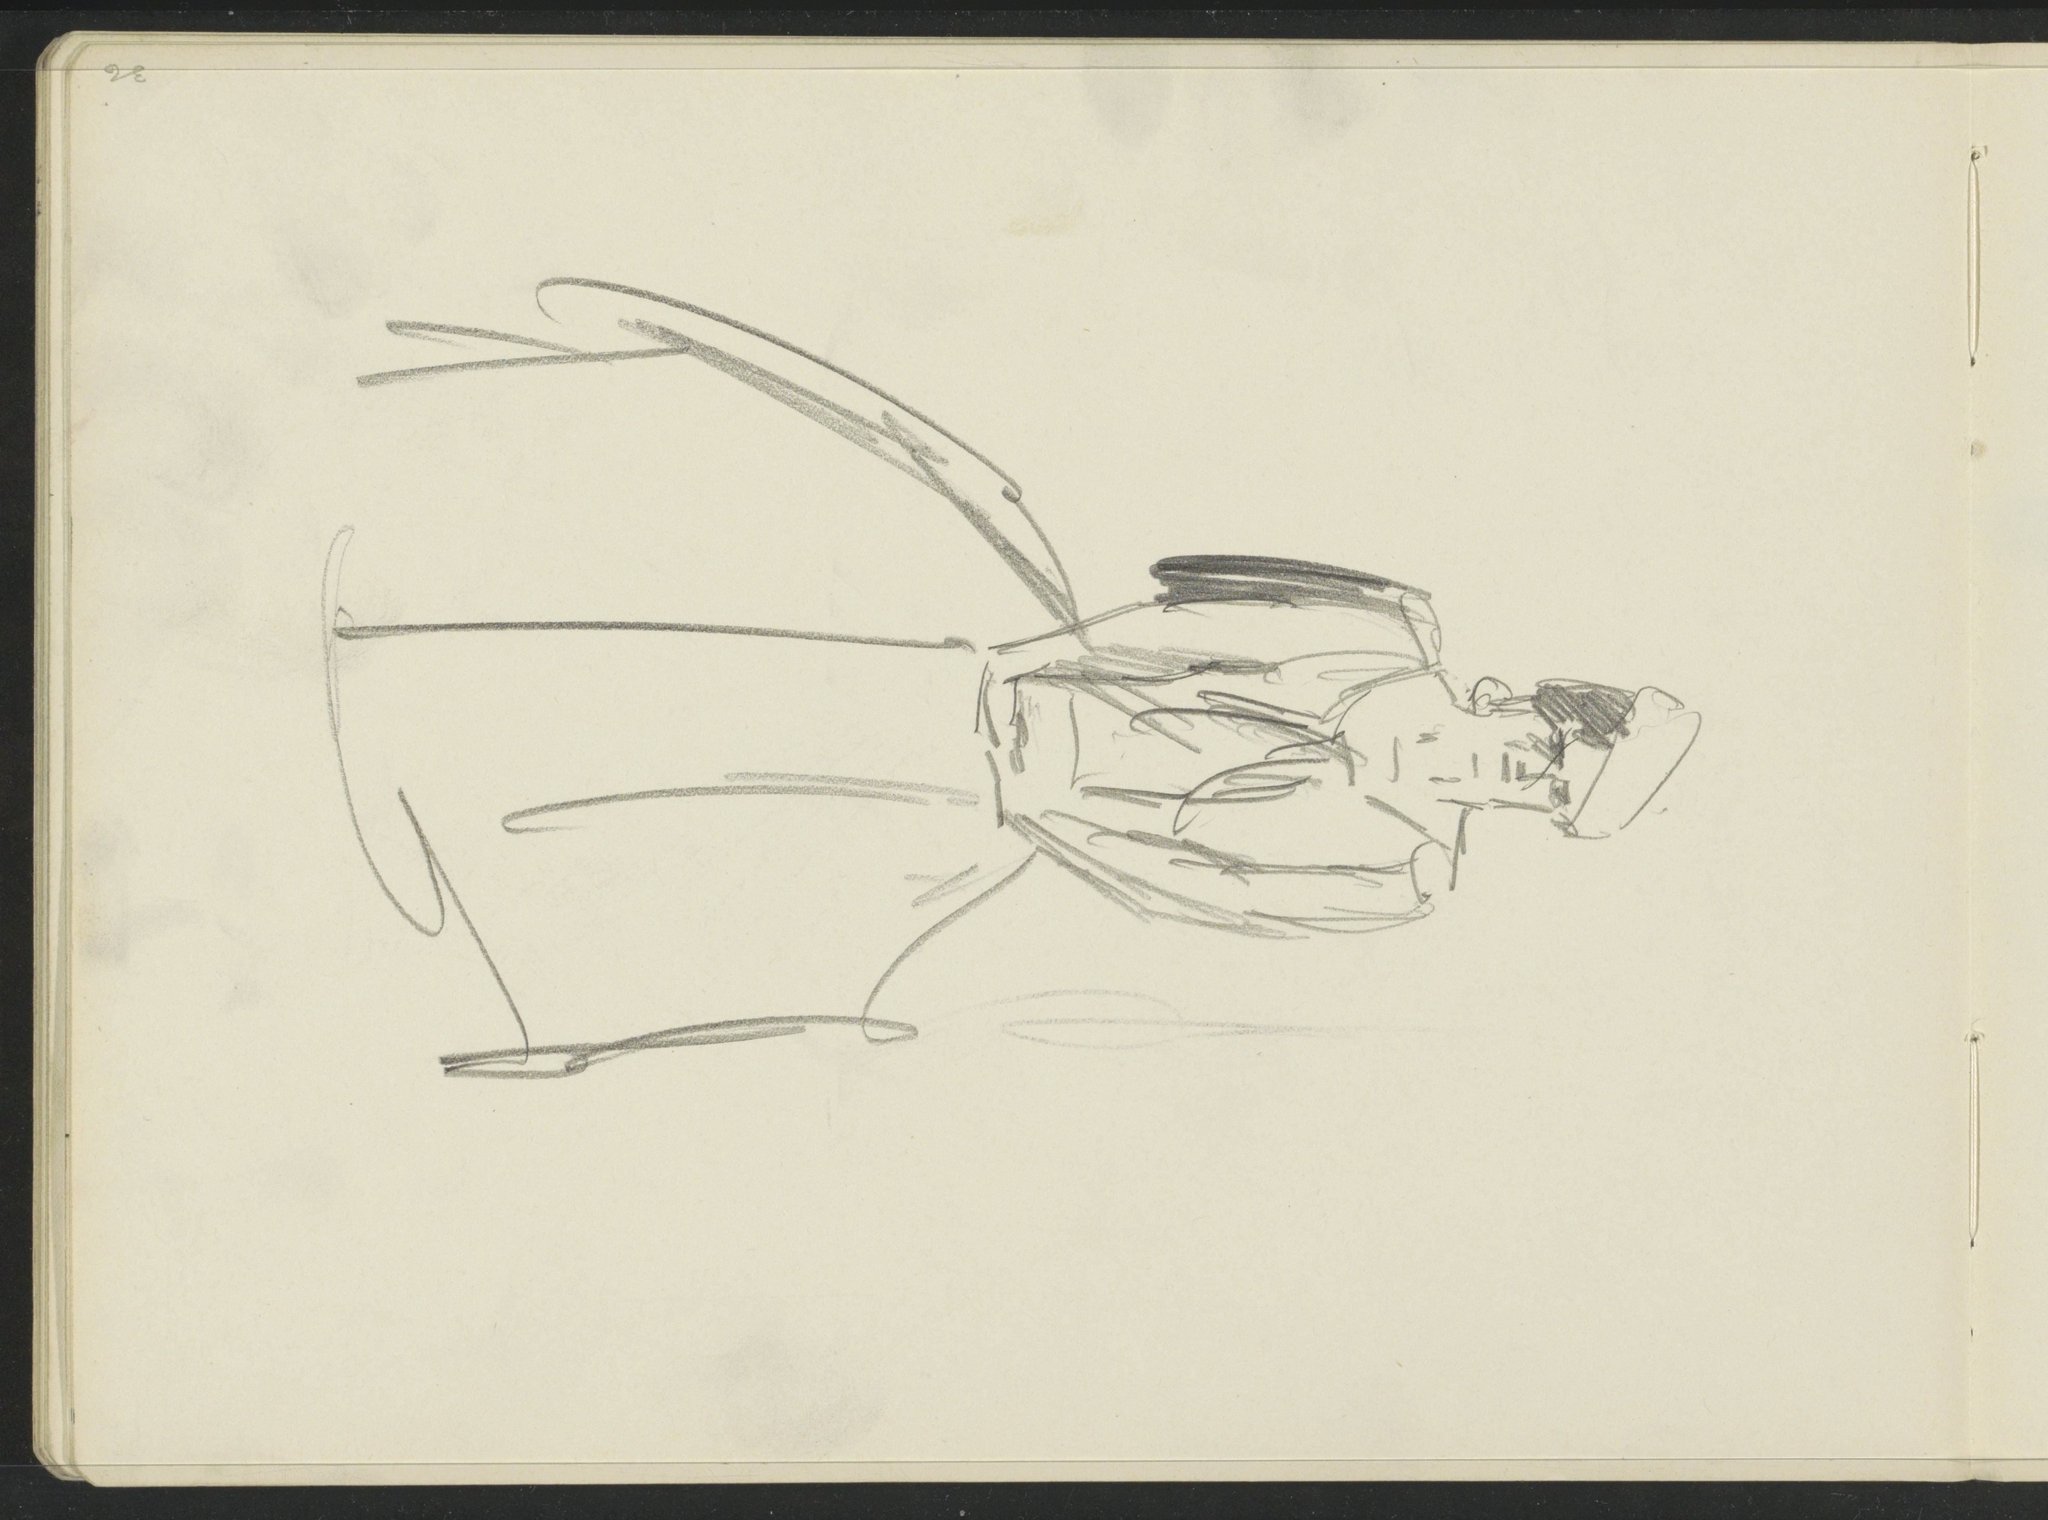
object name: sketchbook leaf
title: Staande vrouw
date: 1915-1934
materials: paper, pencil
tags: adult woman (+ standing)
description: Blad 29 verso uit schetsboek XVI met 32 bladen.